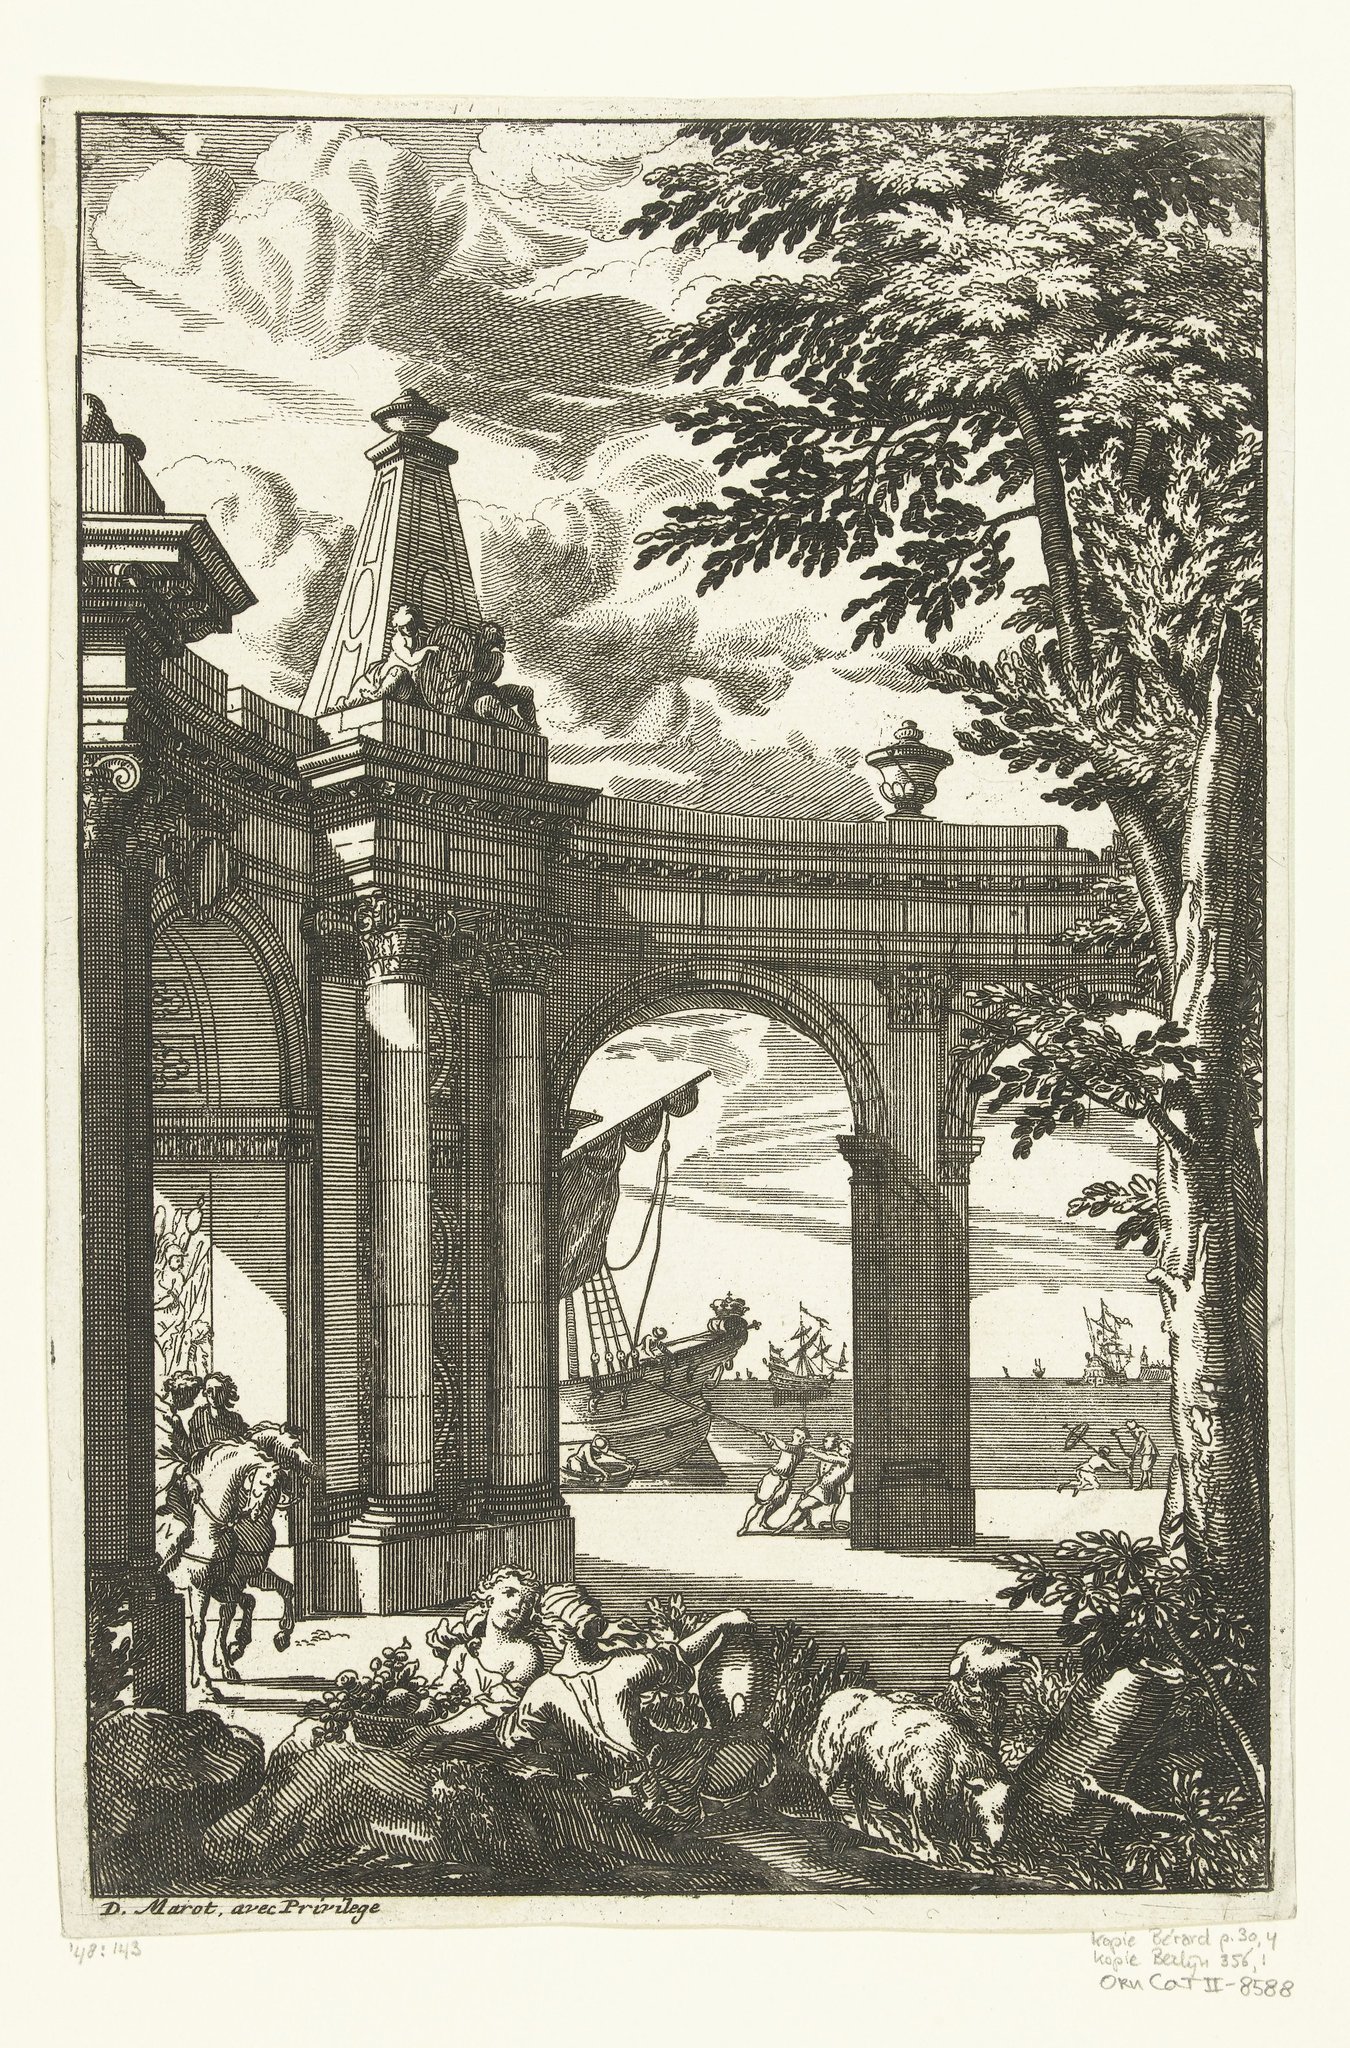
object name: print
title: Colonnade met uitzicht op een haven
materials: paper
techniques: etching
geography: netherlands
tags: harbour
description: Colonnade met vooraan twee vrouwen en twee schapen, rustend in de schaduw van twee bomen. Tegenzijdige kopie naar blad uit serie Nouveau liure de paysages. Uit serie van 6 bladen.